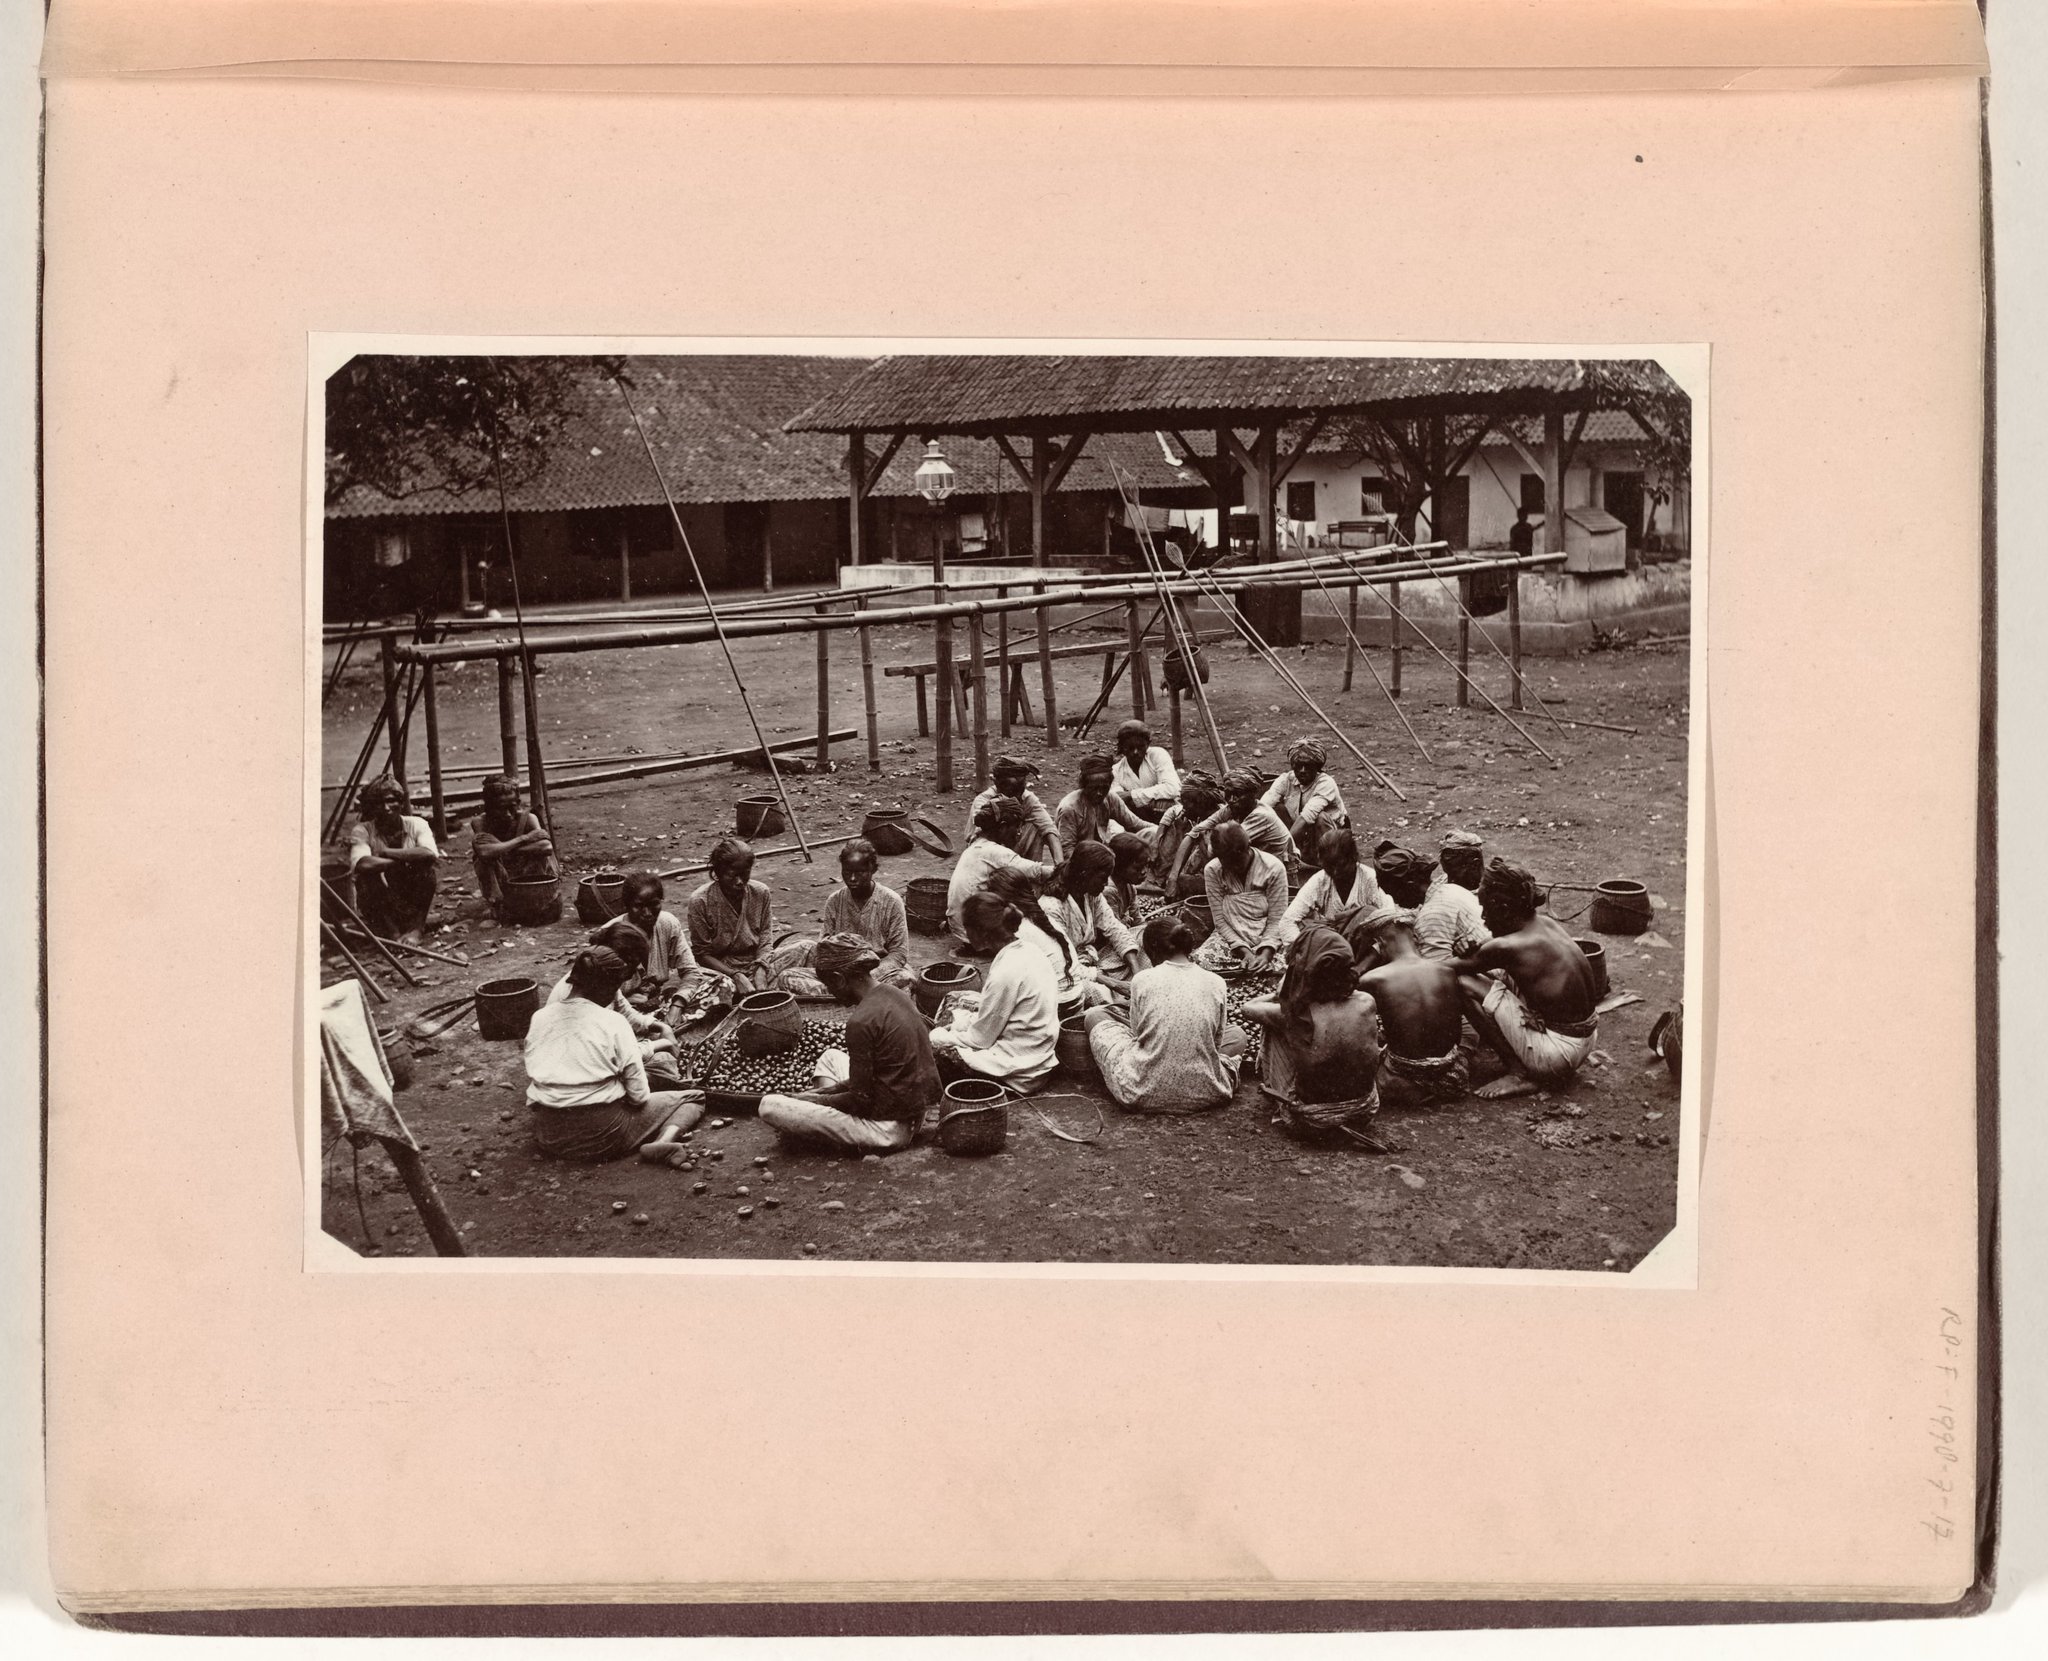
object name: album leaf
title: Bewerking van nootmuskaat door perkeniers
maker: c. dietrich (fotograaf)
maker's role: fotograaf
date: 1875-1890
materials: cardboard, paper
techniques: albumen print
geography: indonesia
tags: fruits: nuts, indonesia